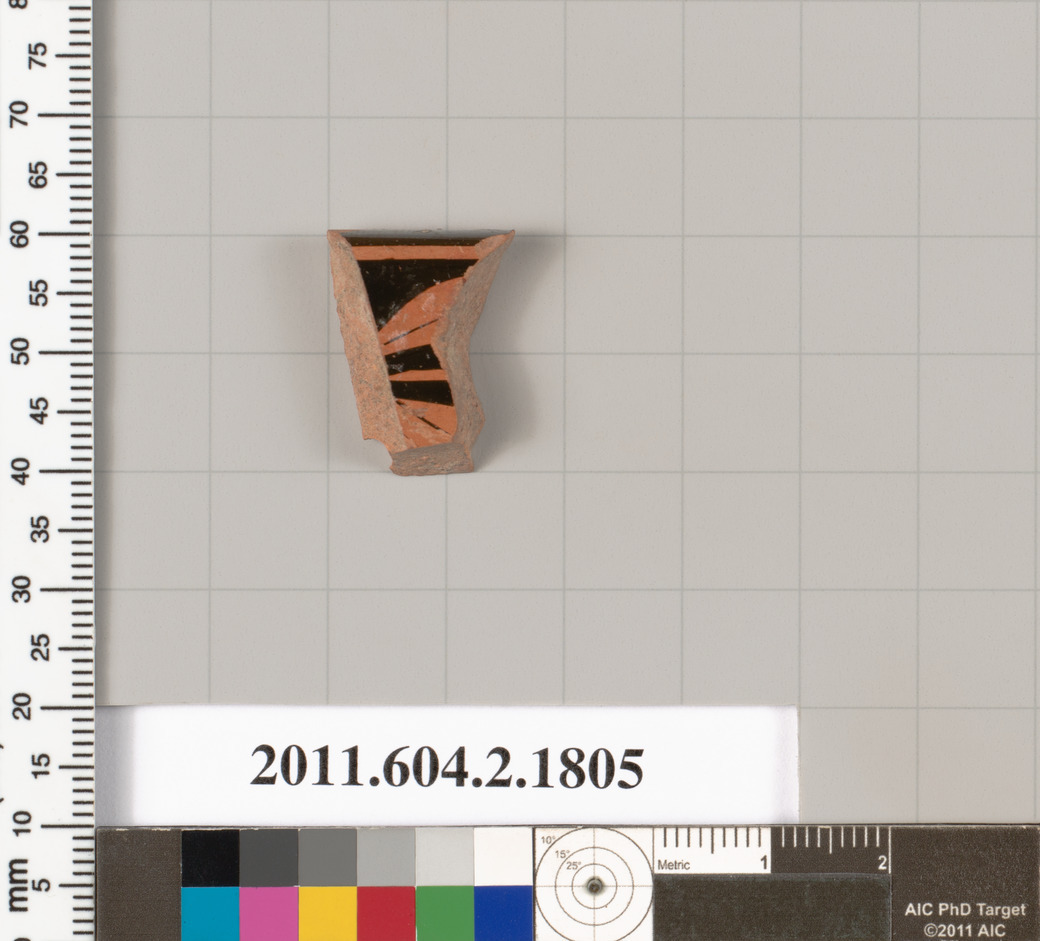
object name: skyphos fragment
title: Terracotta rim fragment of a skyphos (deep drinking cup)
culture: greek, attic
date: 480-470 BCE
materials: terracotta